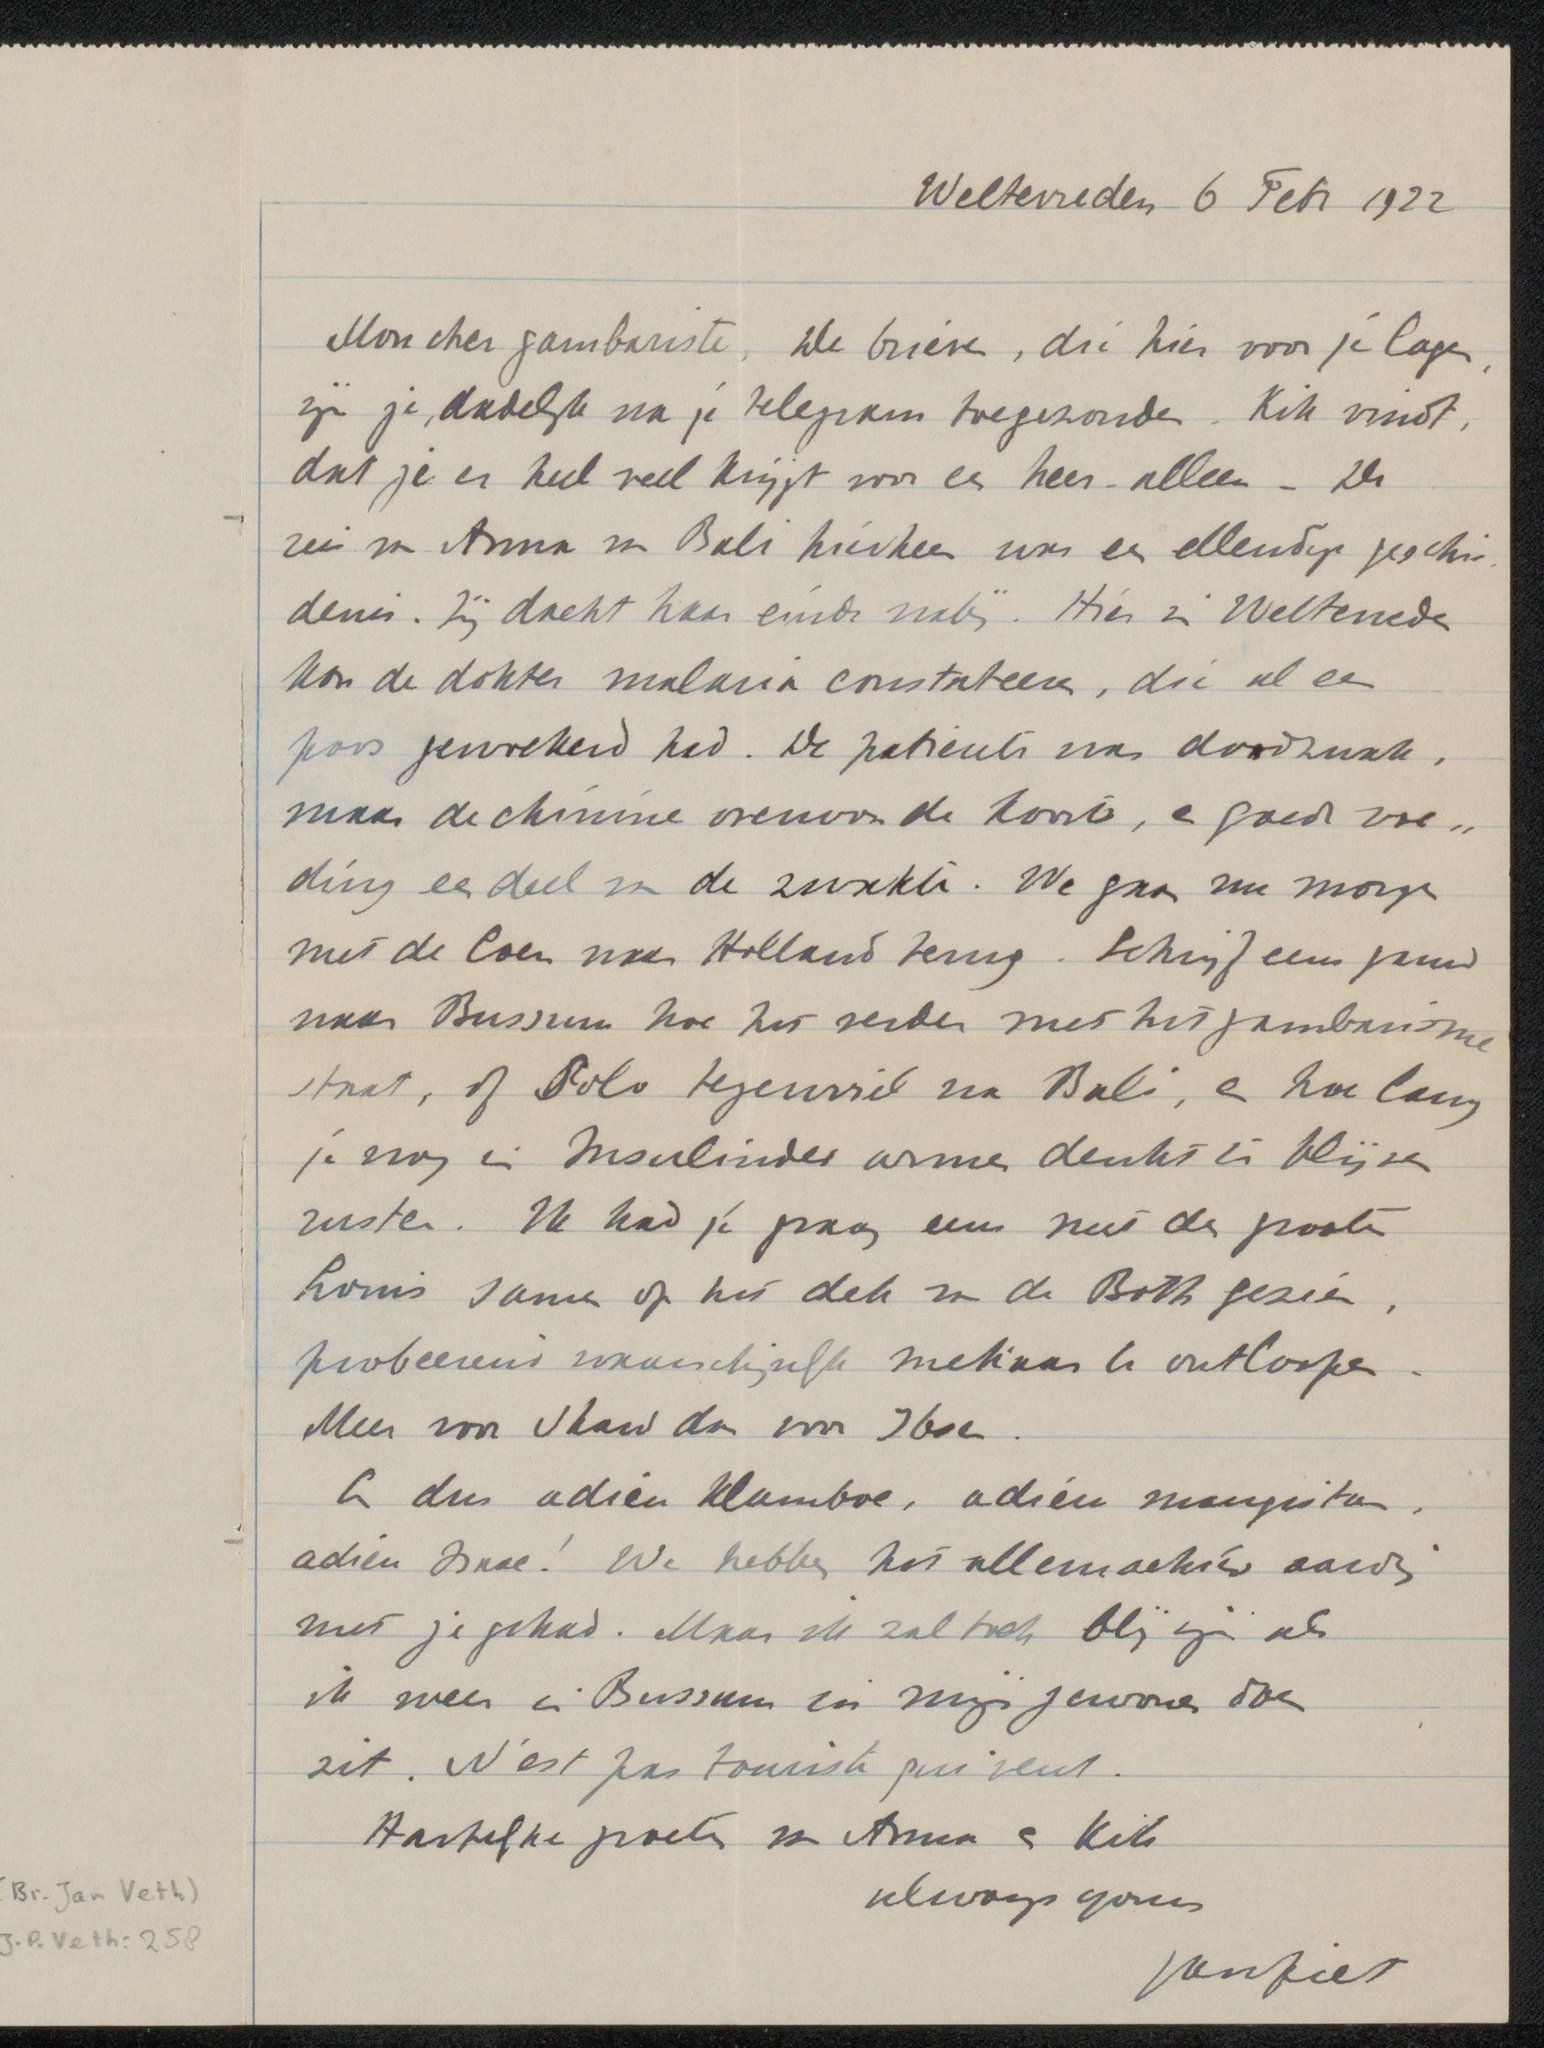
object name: letter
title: Brief aan Isaac Israels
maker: jan veth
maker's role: designer, draughtsman, painter, print maker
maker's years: 1864-1925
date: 1922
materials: ink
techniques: pen, writing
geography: weltevreden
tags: amsterdam, painter, print maker, draughtsman, isaac israels, artist, anna dorothea dirks, diseases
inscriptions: collector's mark: ‘RPK’